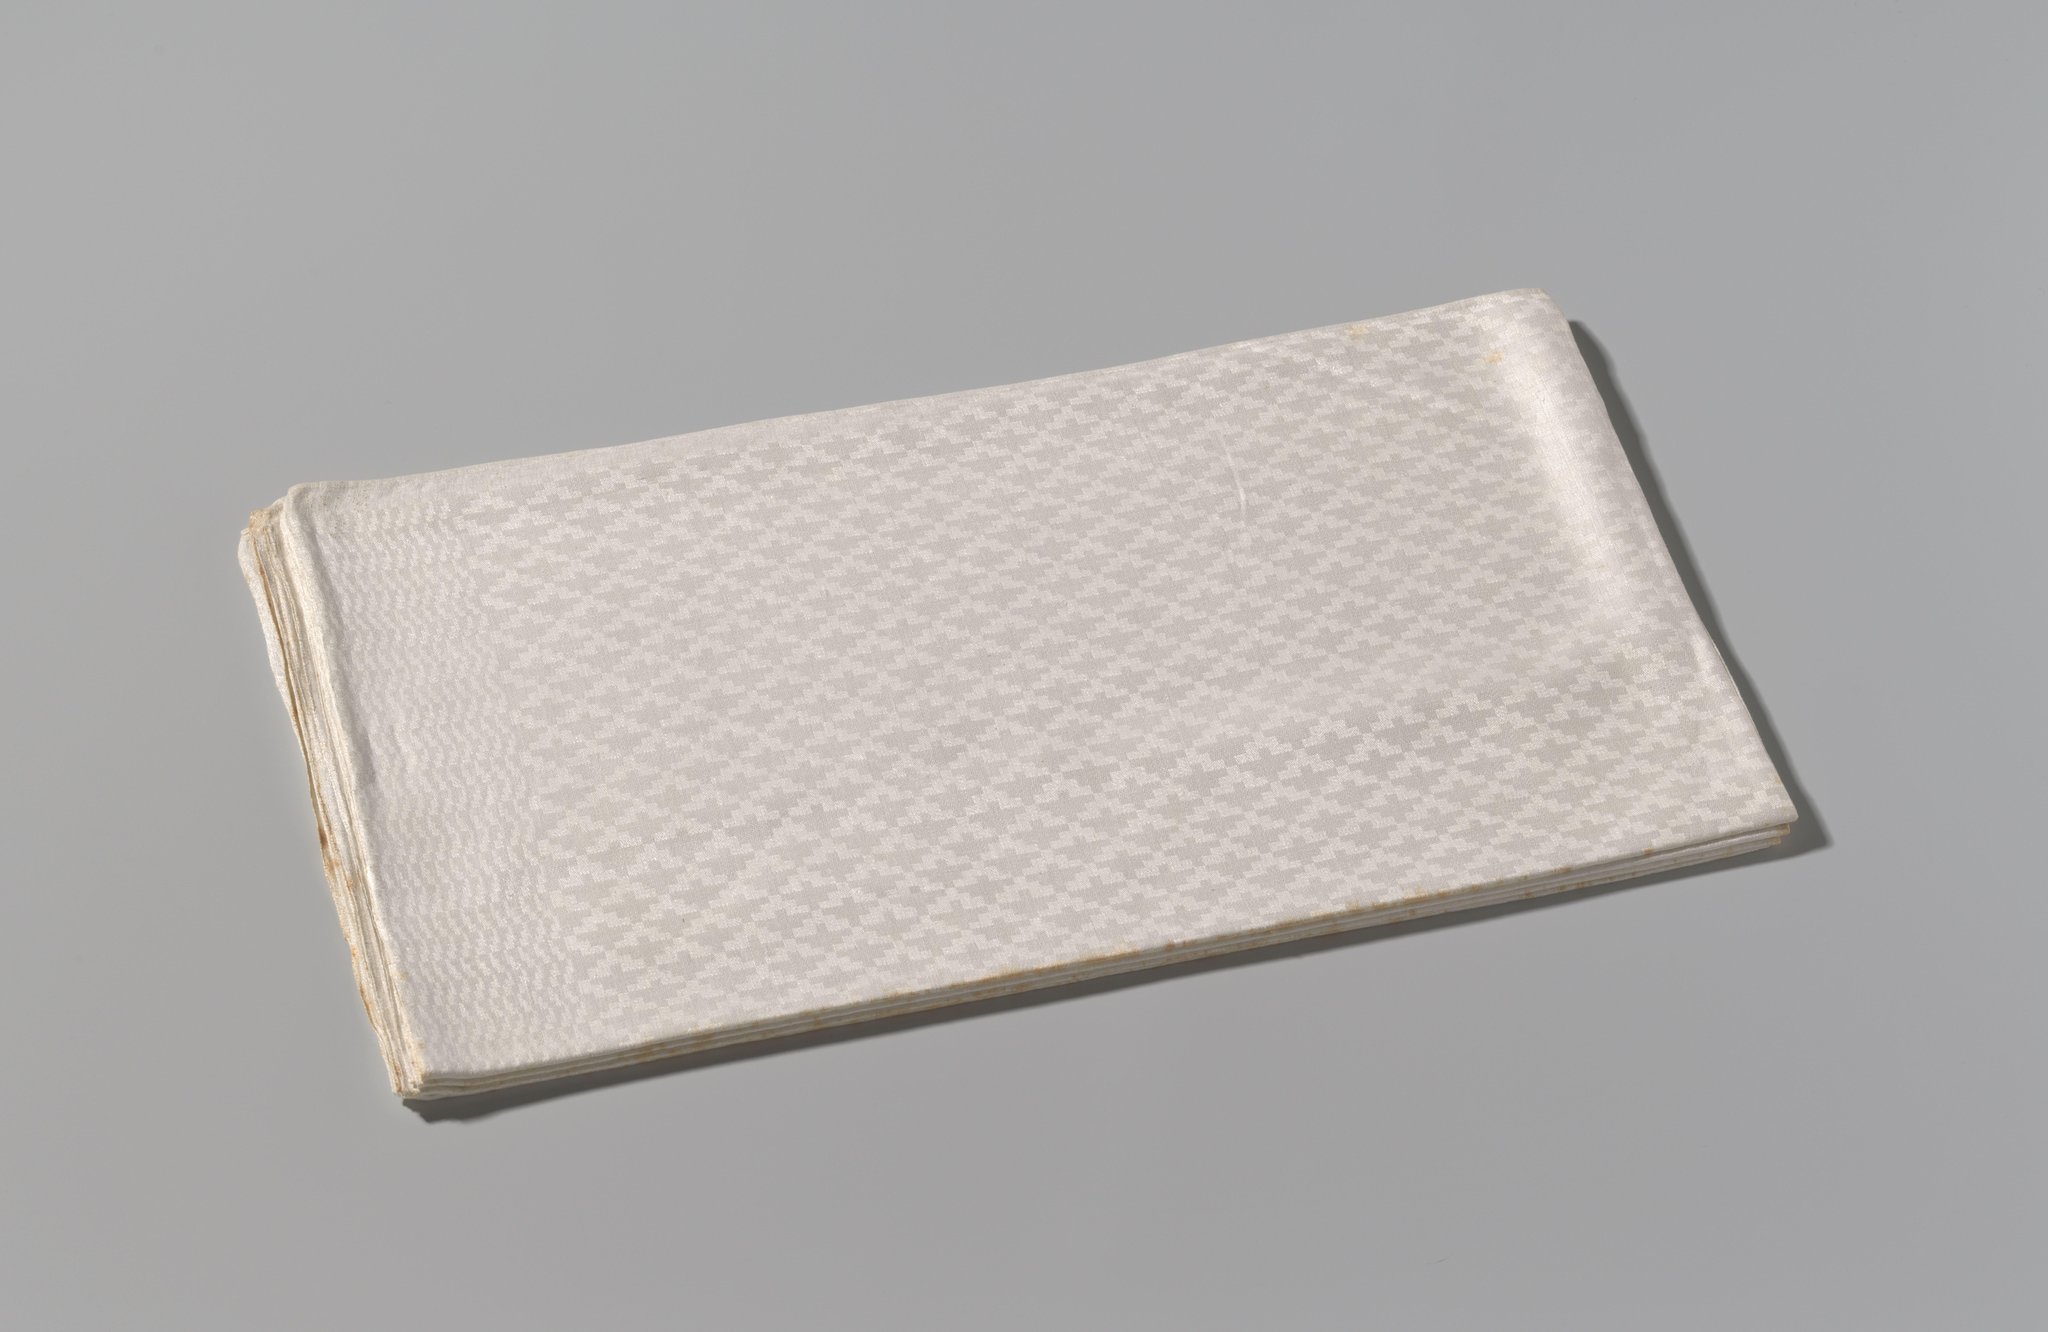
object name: tablecloth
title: Tafellaken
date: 1775-1816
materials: linen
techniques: peeled fabric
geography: netherlands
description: Wit linnen tafellaken met een pellen patroon en randen rondom, merk WS 5 en bloemetje met R aan steel 58 WH 2oonl.